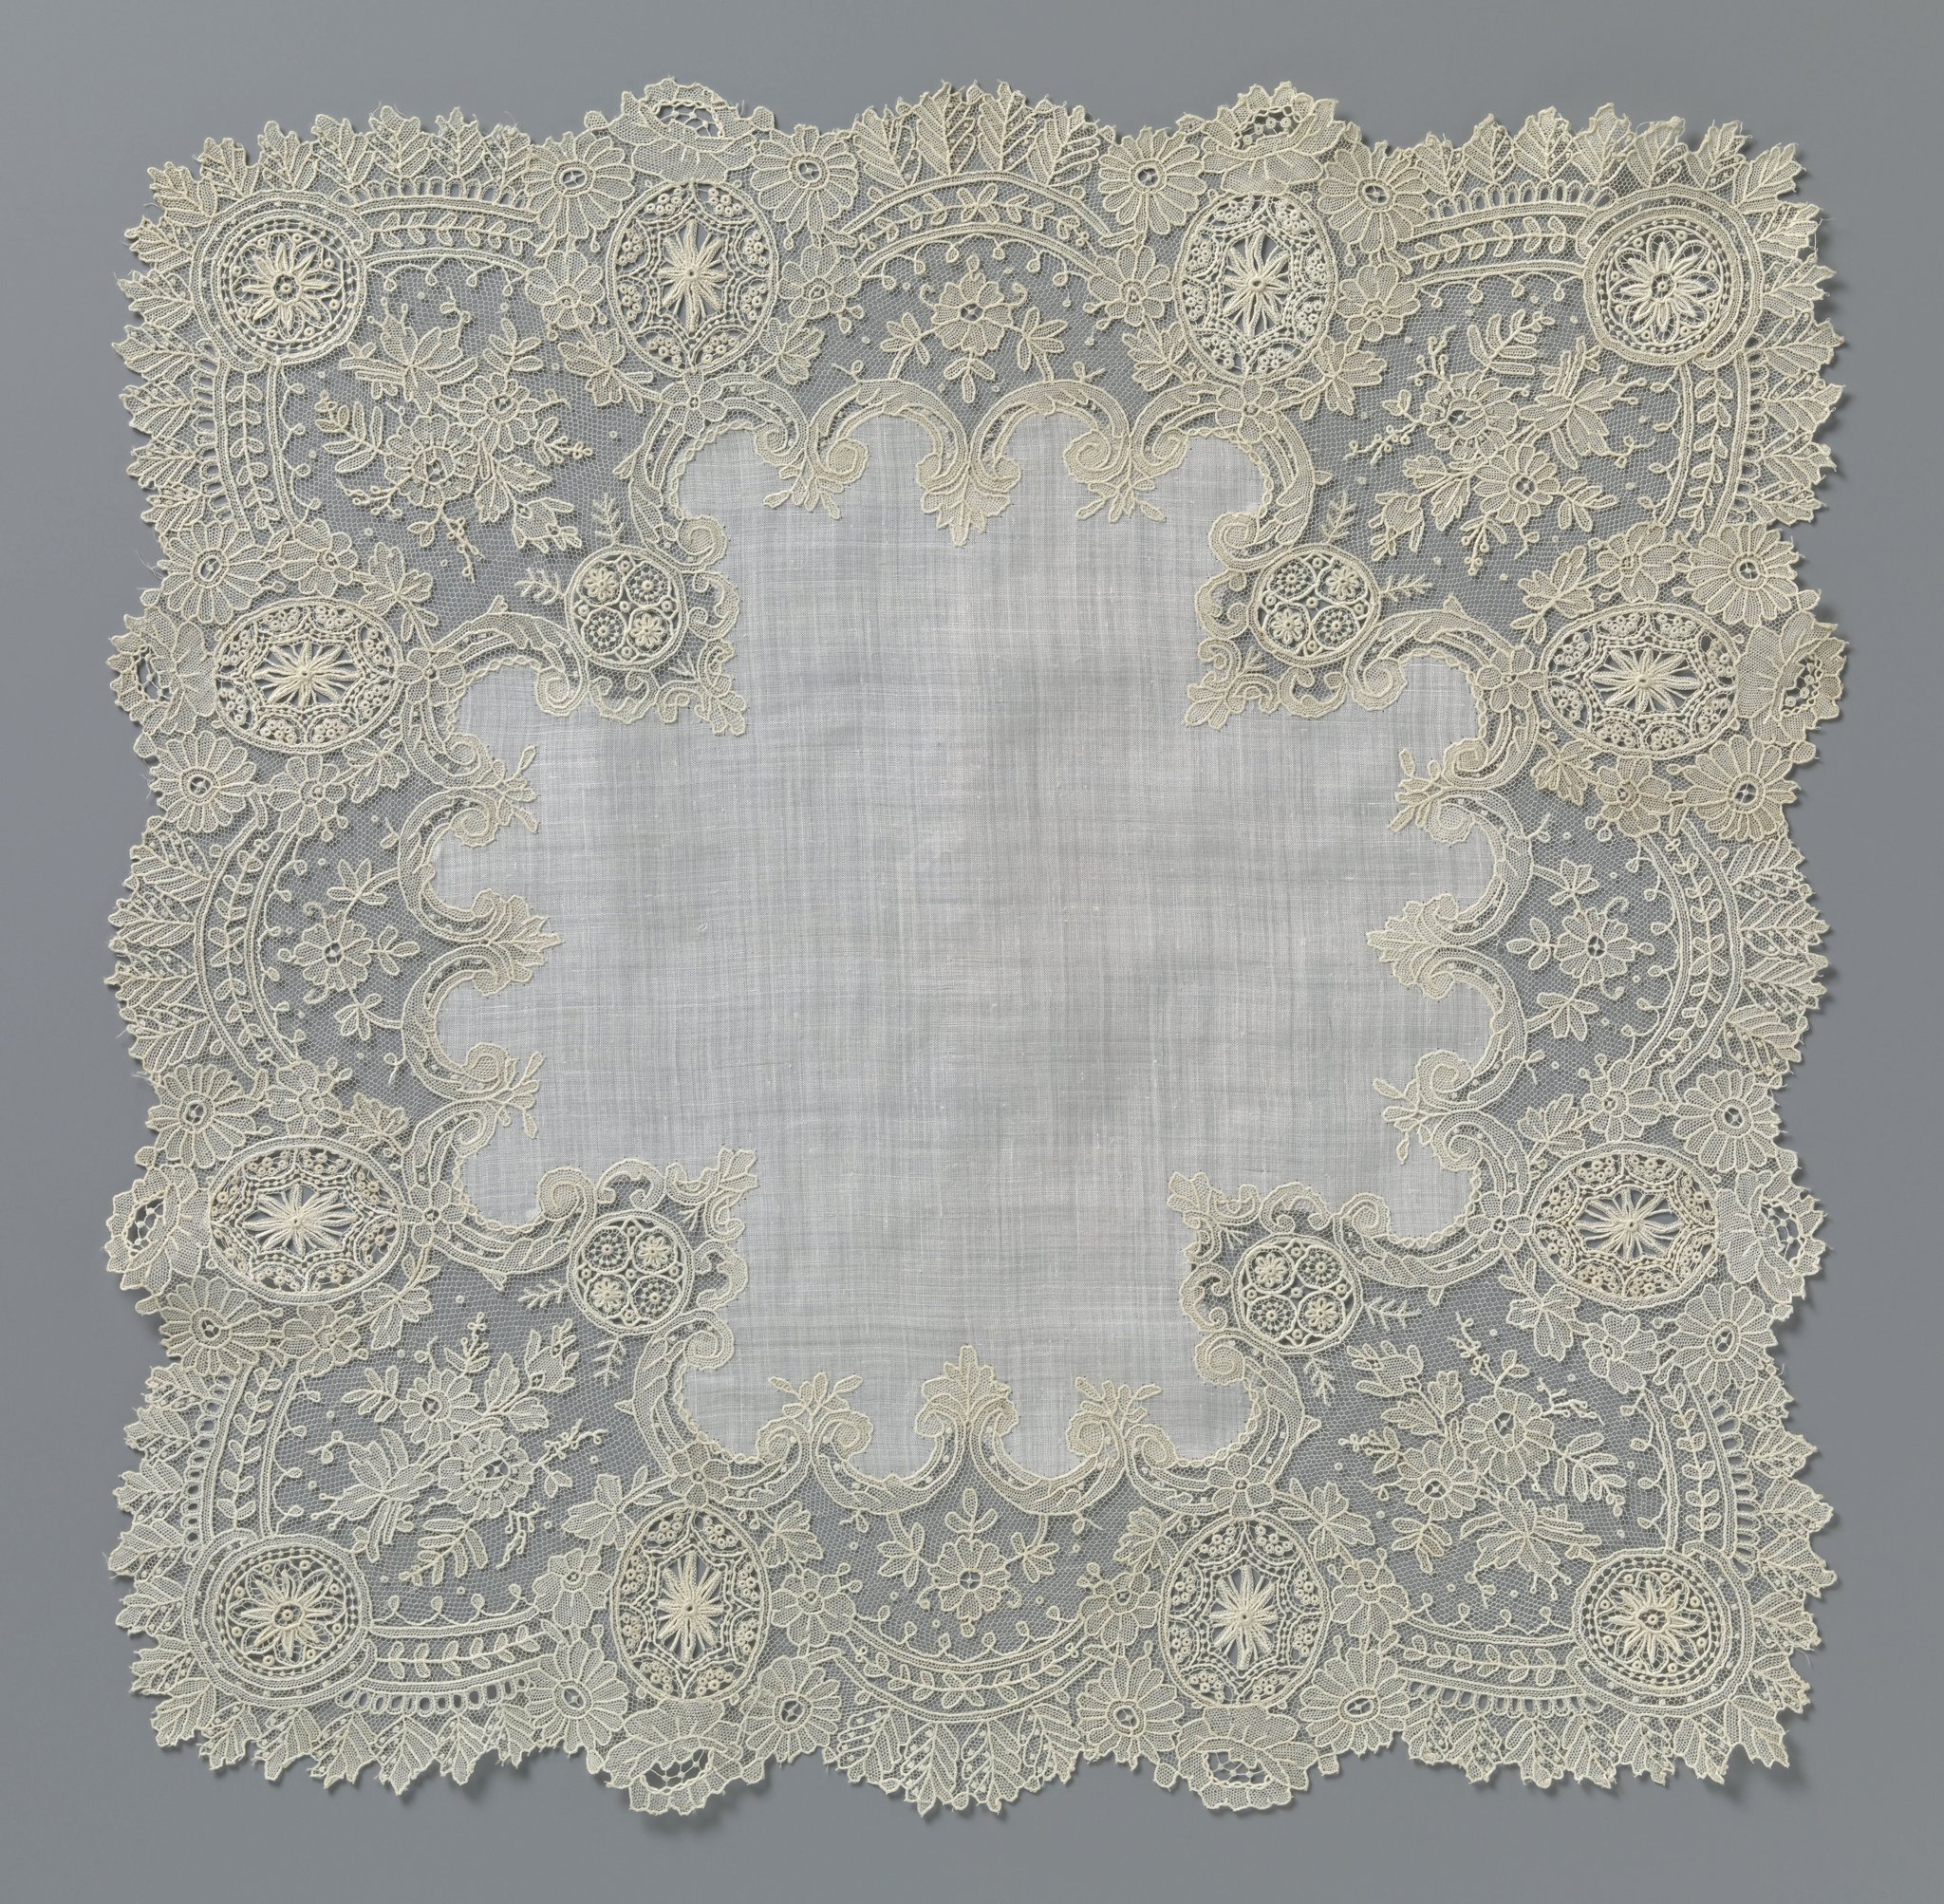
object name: handkerchief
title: Zakdoek met een rand van naaldkant met acht ovalen en acht cirkels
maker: Anonymous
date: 1870-1890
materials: linen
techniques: lace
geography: brussels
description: Zakdoek met een rand van naturelkleurige naaldkant, Brusselse gaaskant. Rondom een groot kruisvormig batisten middenstuk loopt een smalle kantrand met acht diepe schulpen, waarvan de sluitstukken gevormd worden door acht ovalen. De hoekschulpen vertonen telkens twee boven elkaar staande cirkeltjes. De schulprand bestaat uit een bladtakje en een rand van blaadjes, die de schulpjes vormen. Kleine, holle c-voluten vormen de binnenrand.